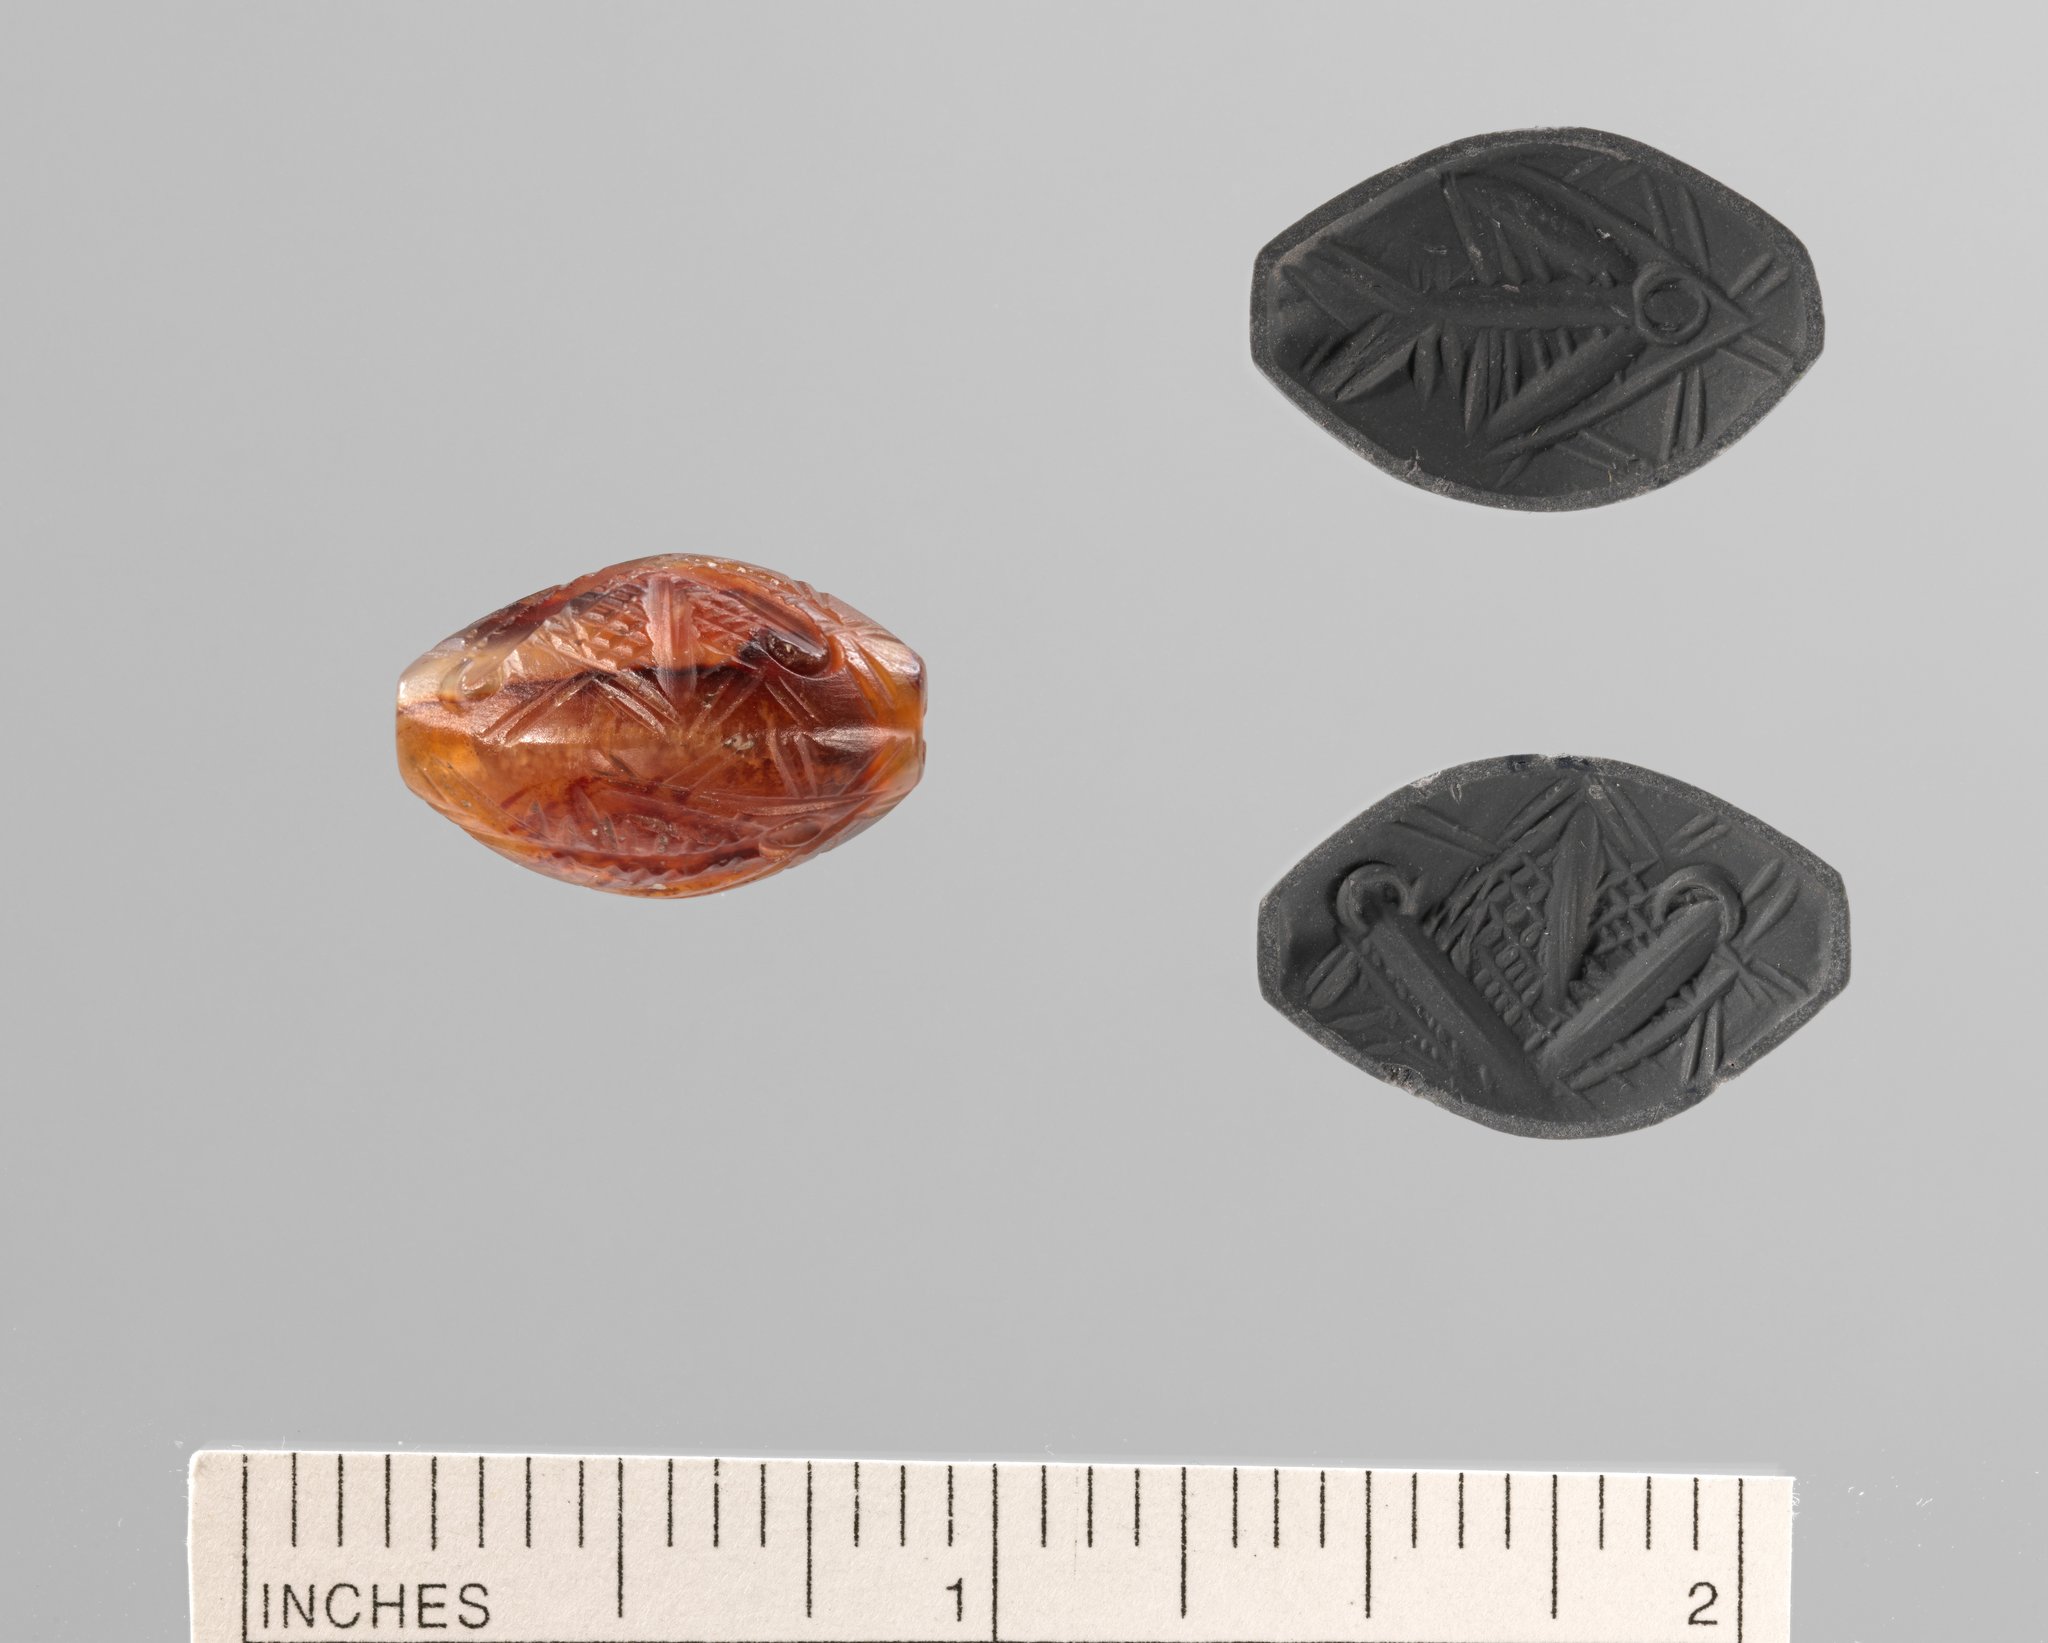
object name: prism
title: Sard Prism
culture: minoan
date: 1650-1500 BCE